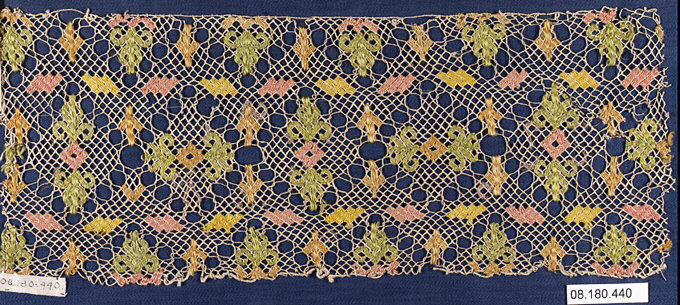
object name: fragment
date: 1601-1700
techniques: embroidery